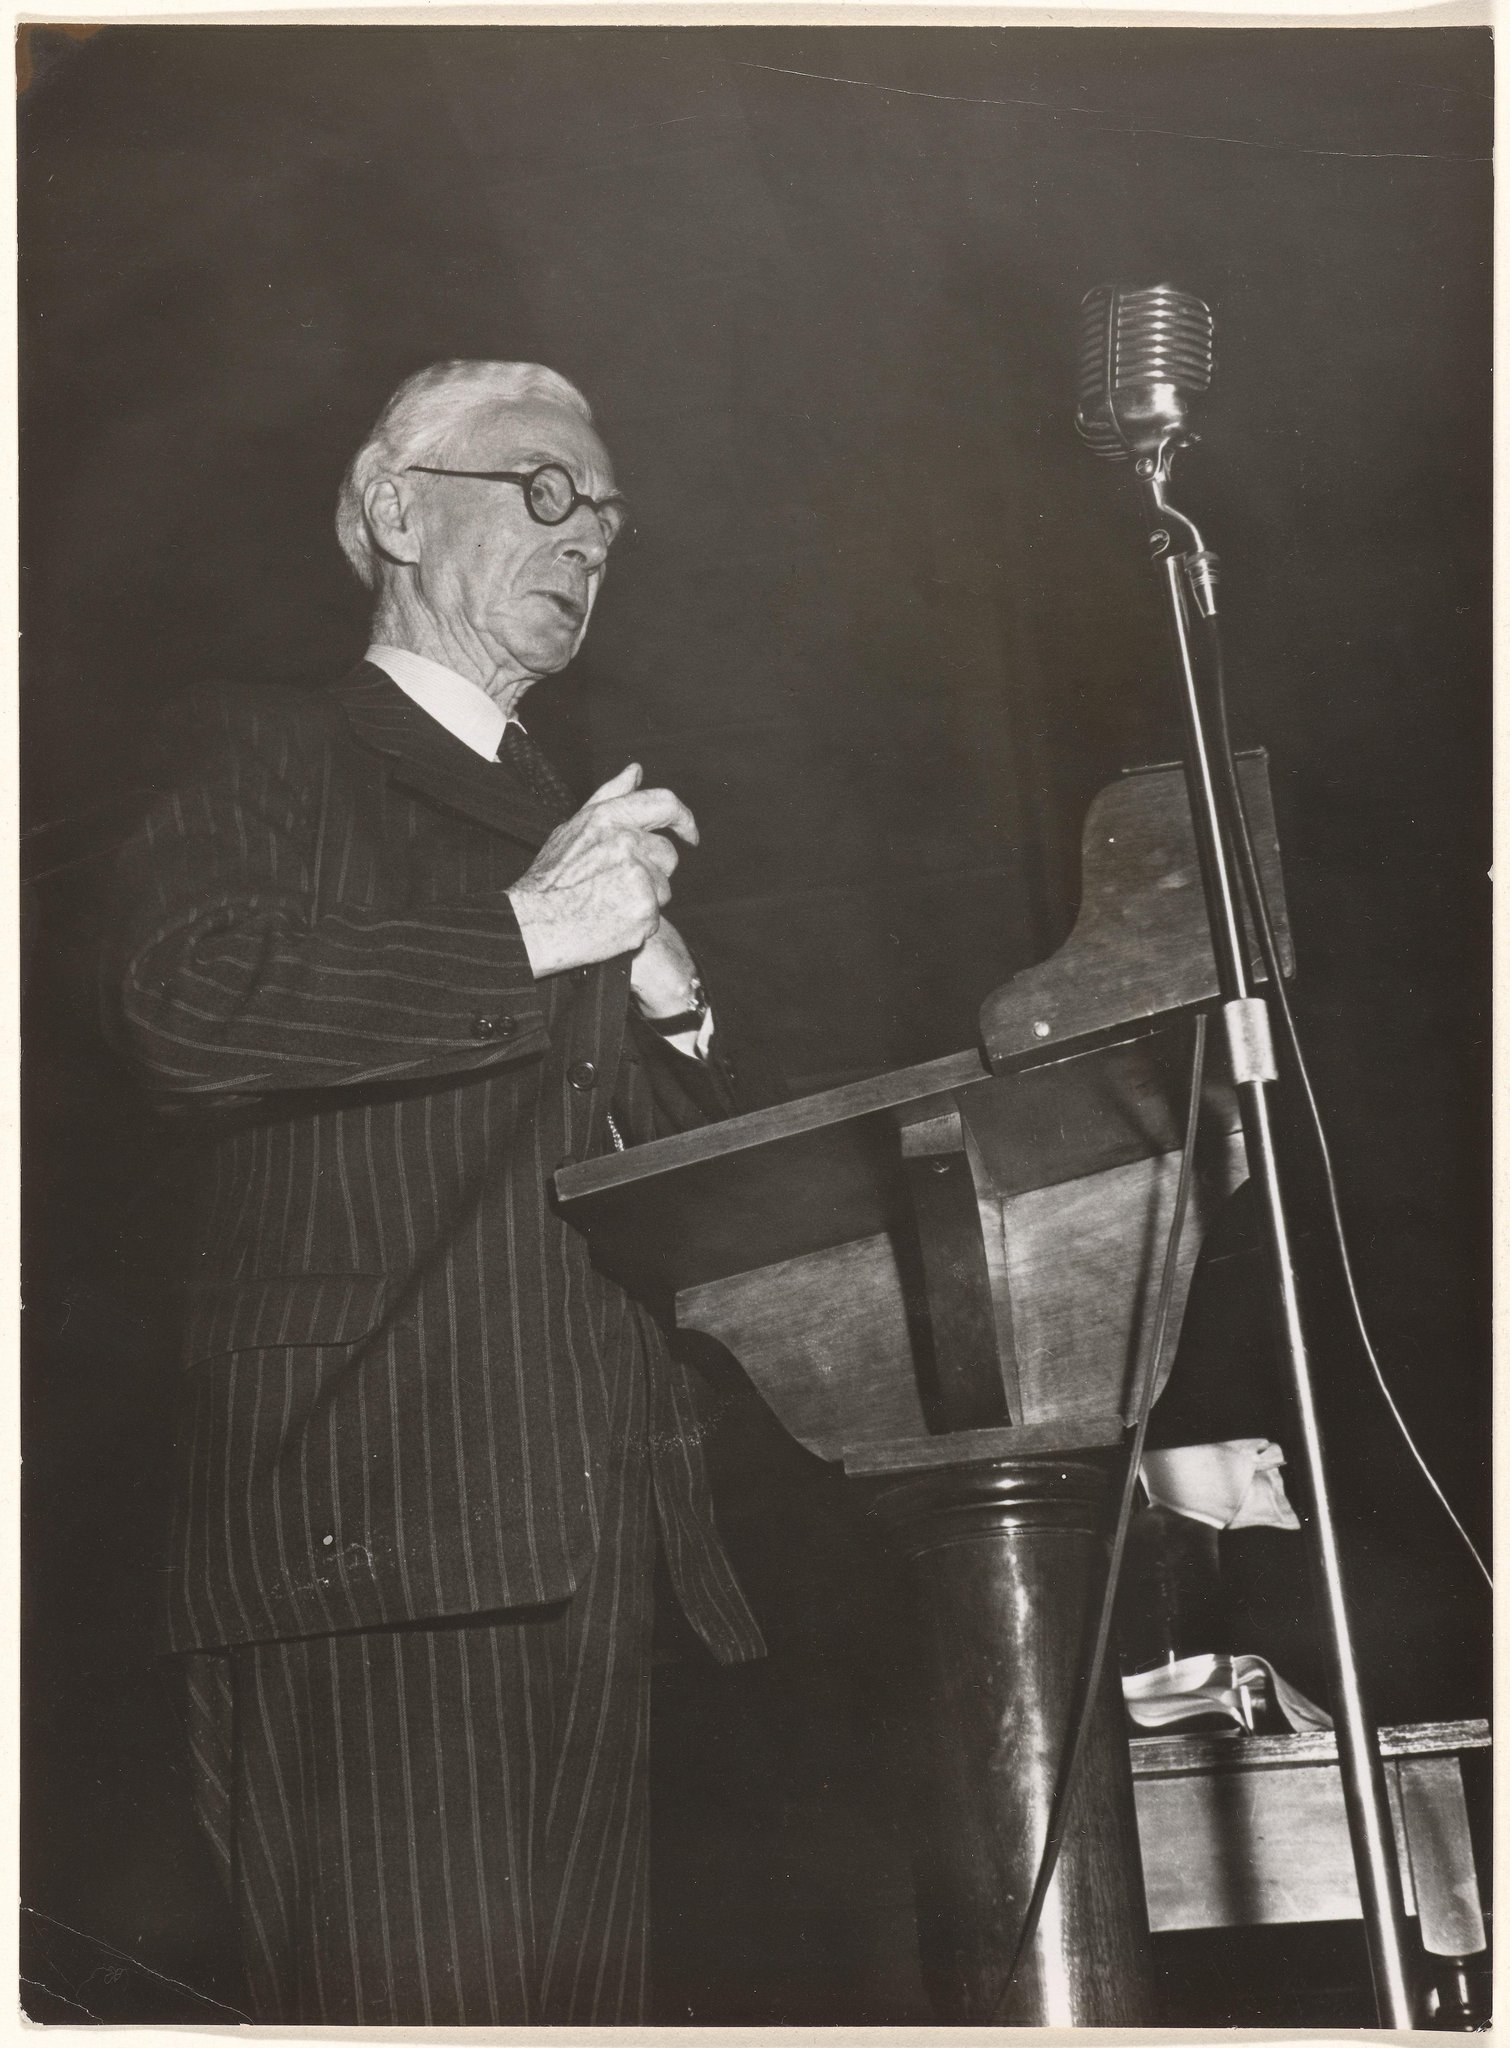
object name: photograph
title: Bertrand Russell tijdens rede Columbia University, N.Y. 1950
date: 1950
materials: photographic support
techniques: gelatin silver print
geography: london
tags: wetenschapper, bertrand russell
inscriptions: stamp: ‘Keystone press agency LTD’